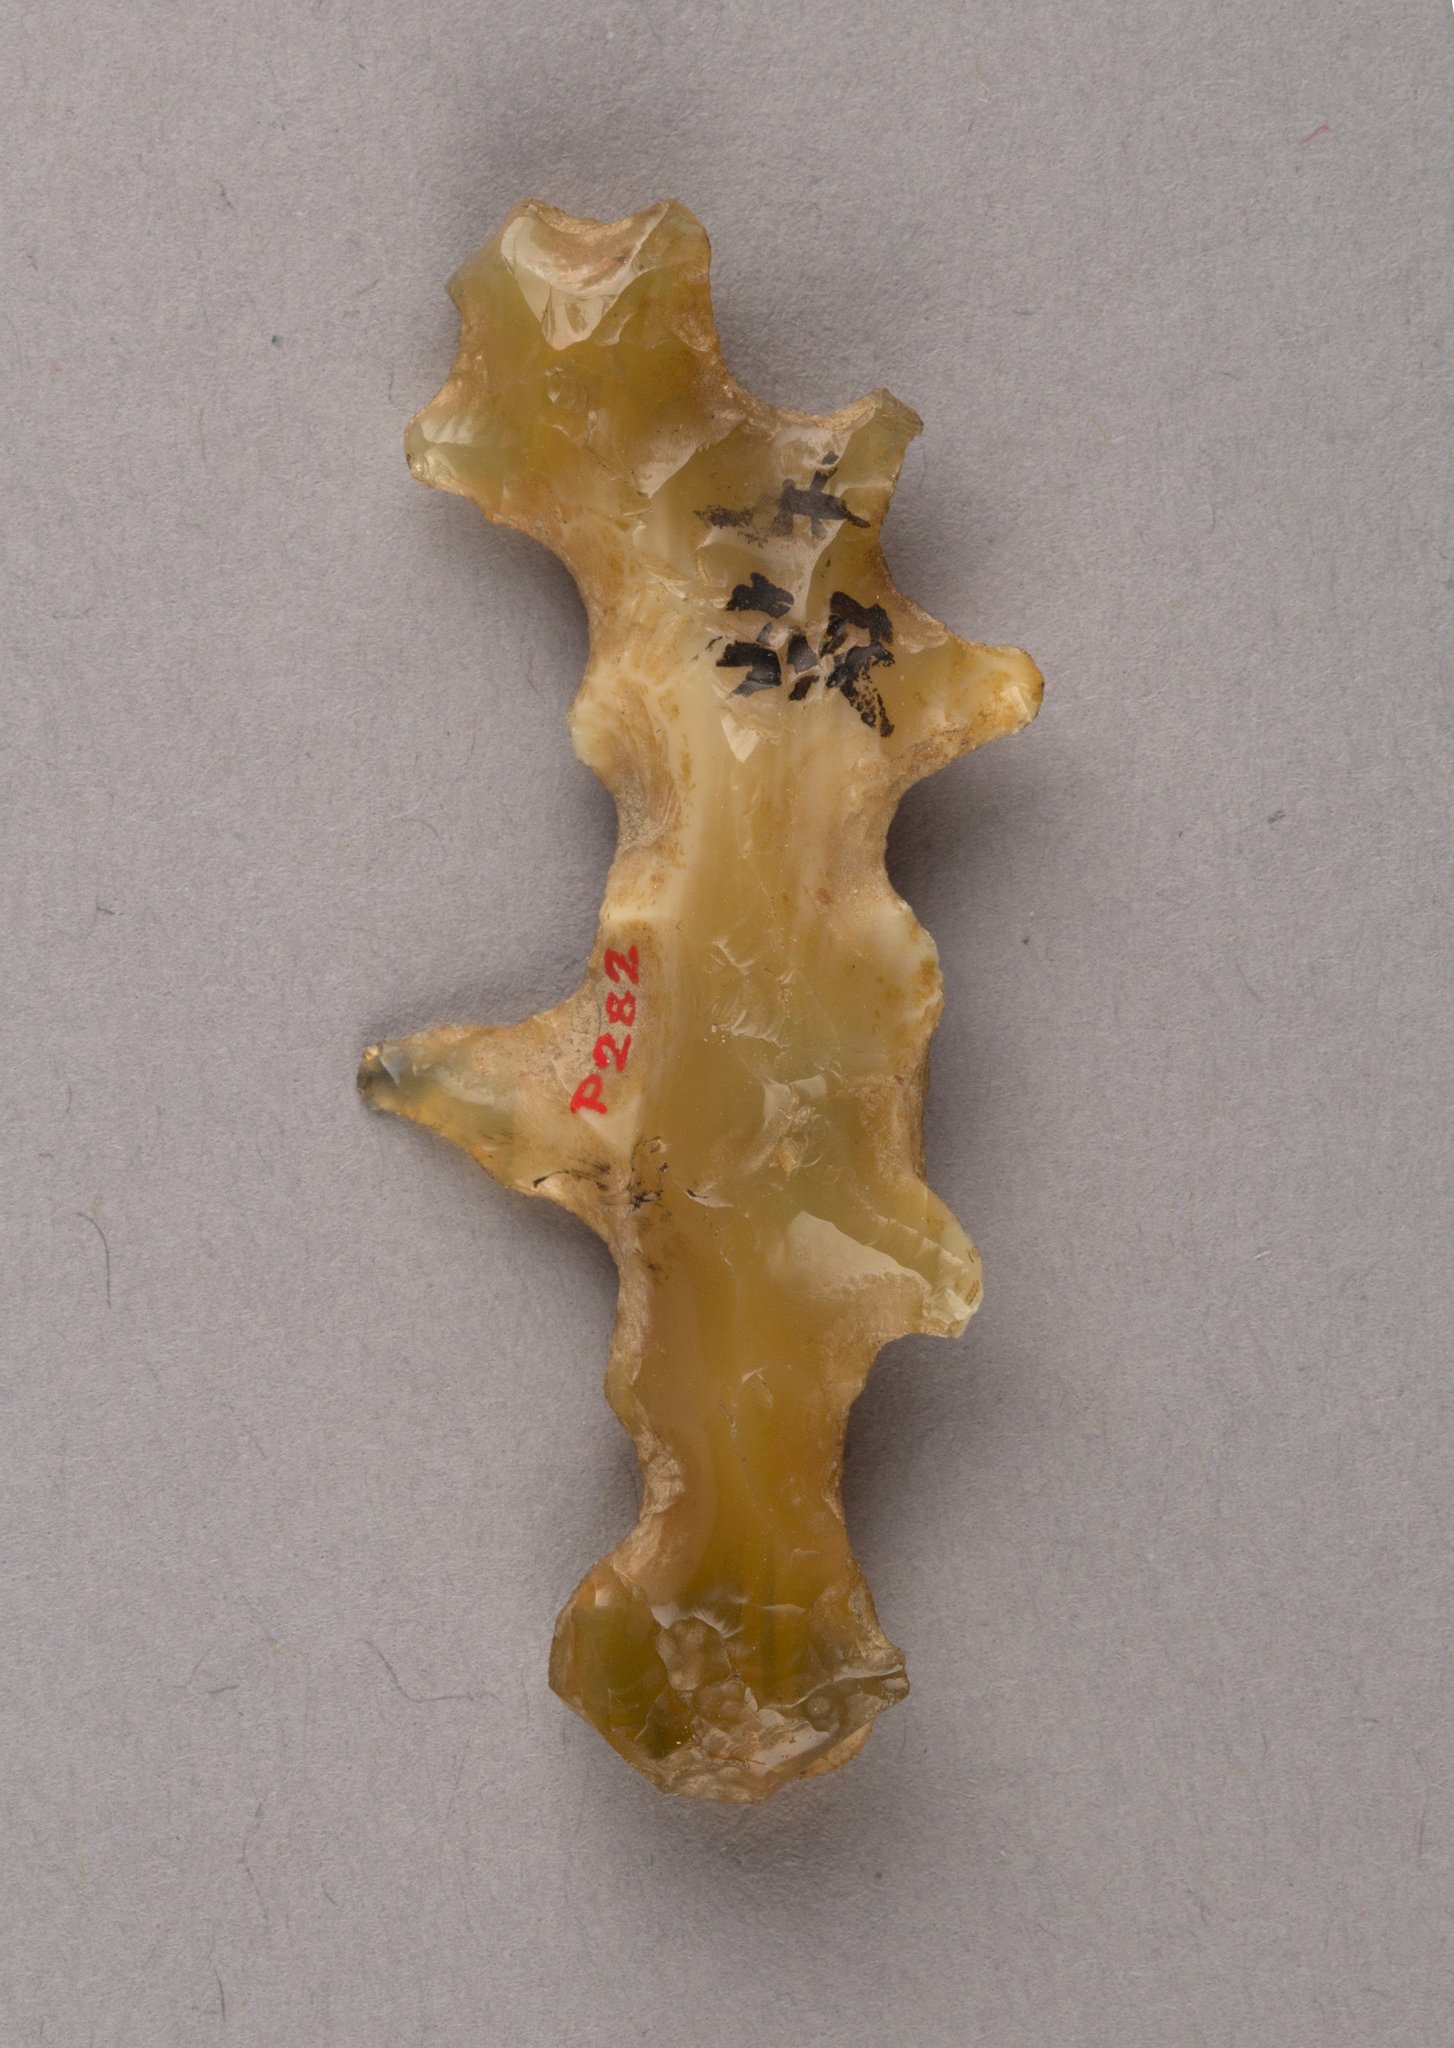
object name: harpoon head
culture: japanese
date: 1000-300 BCE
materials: bone